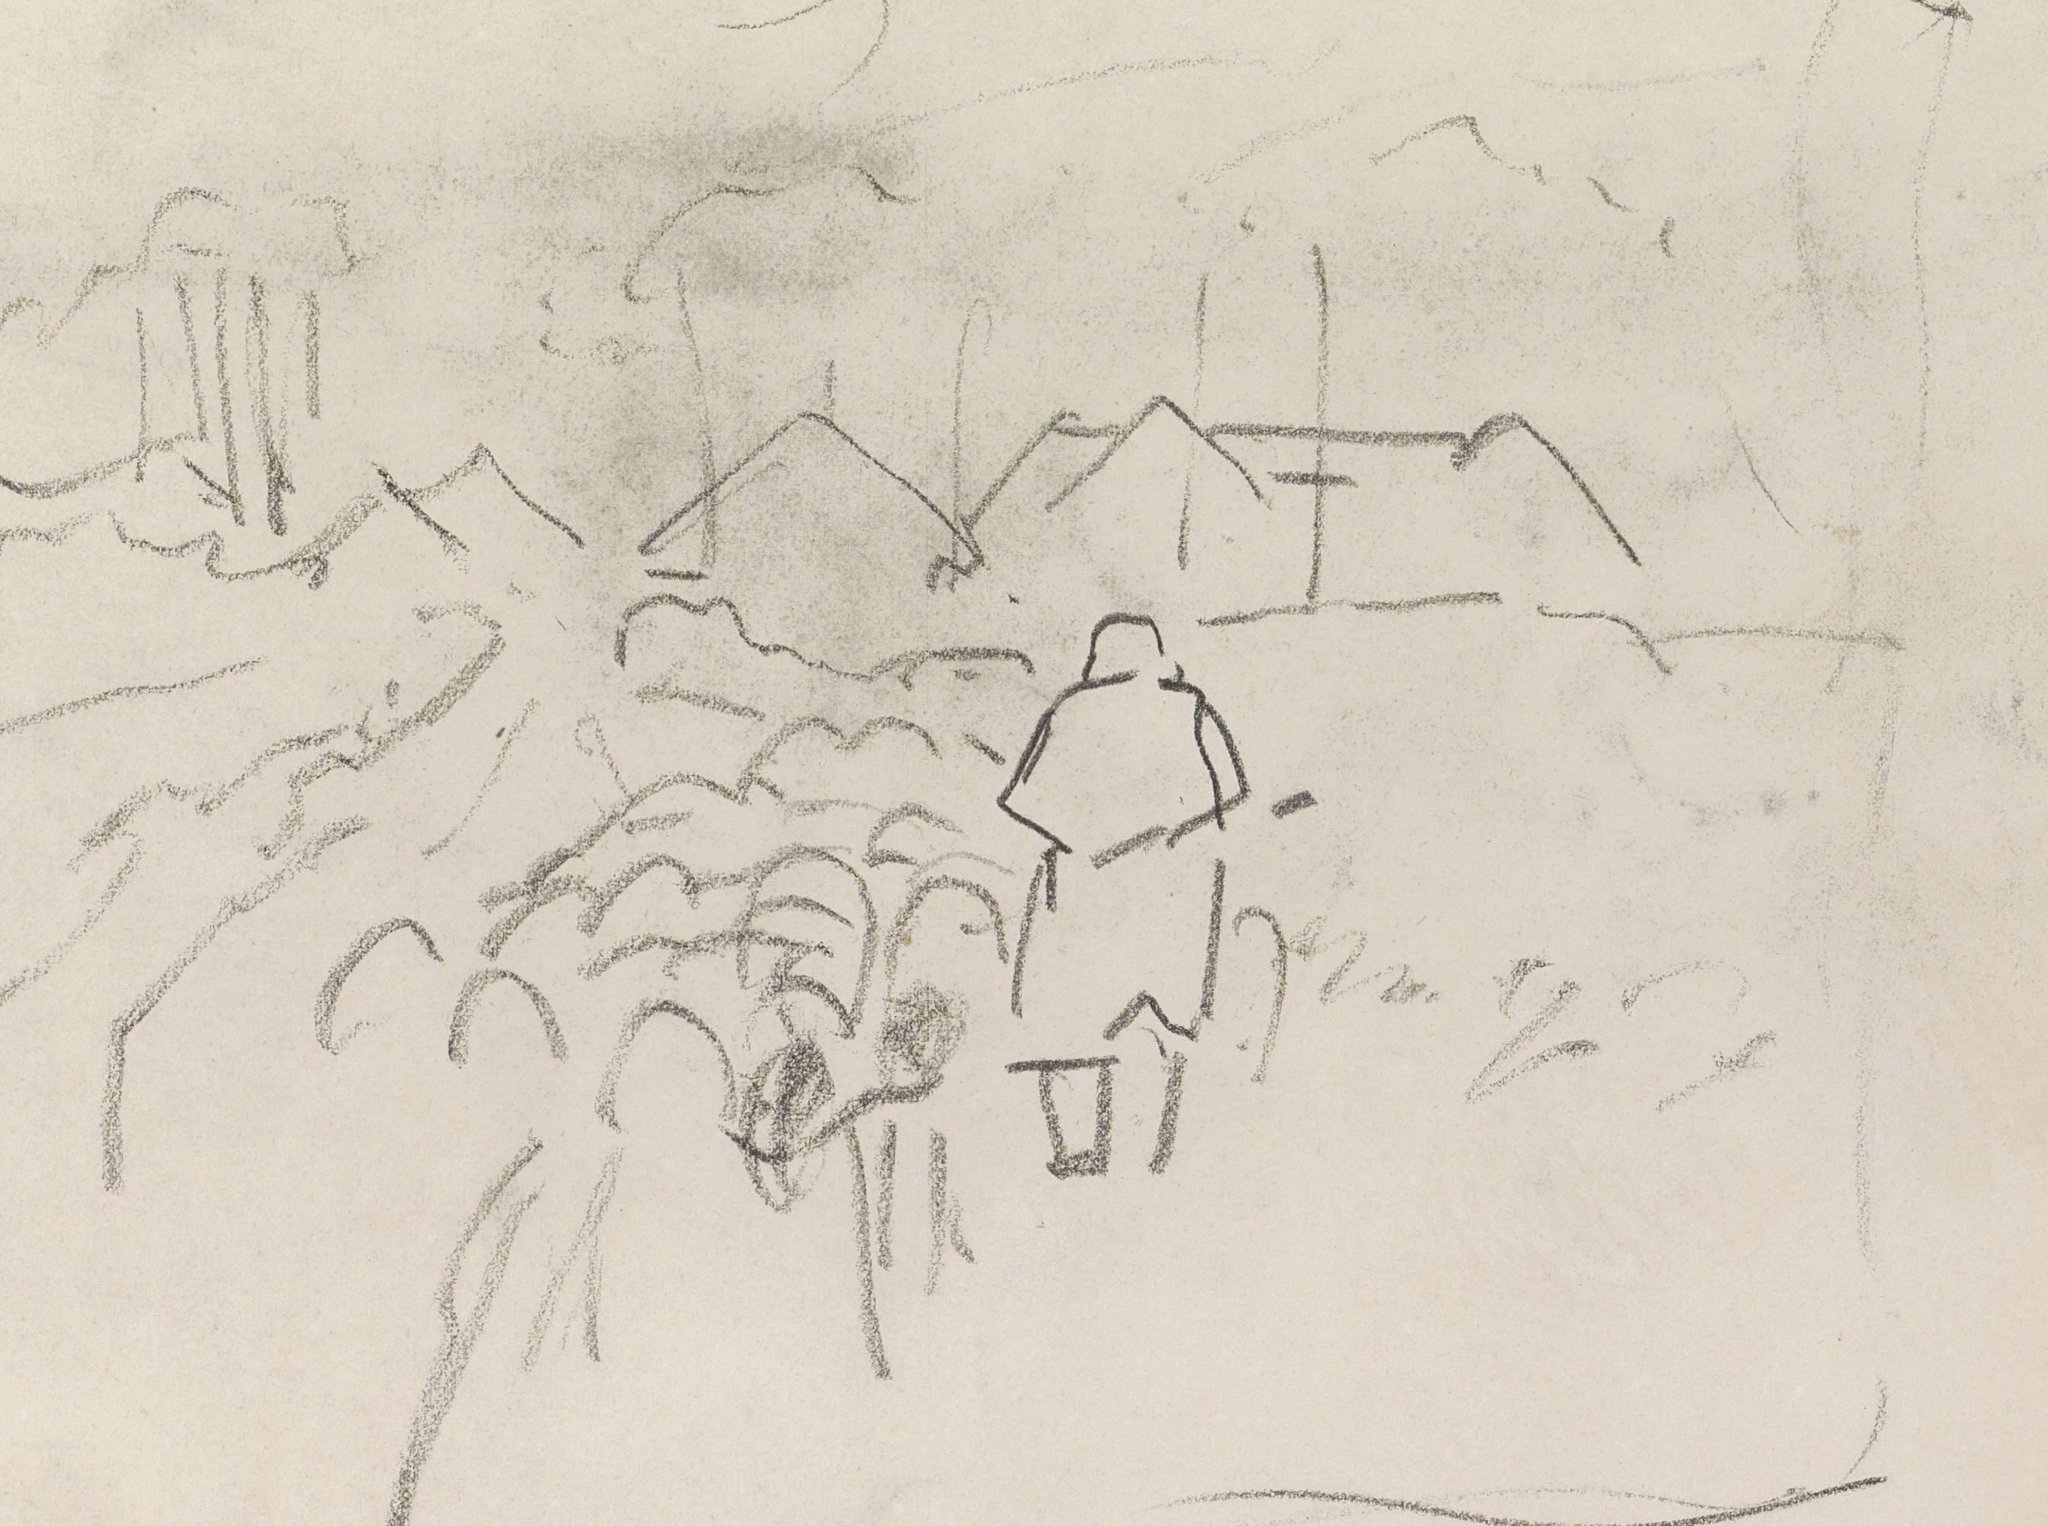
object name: sketchbook leaf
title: Herder met een schaapskudde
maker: anton mauve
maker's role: draughtsman, painter, print maker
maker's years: 1838-1888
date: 1886-1888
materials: chalk, paper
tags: herding, herdsman, herdswoman, shepherd, shepherdess, cowherd, etc., sheep, herd, flock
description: Op de achtergrond huizen, mogelijk van een boerderij. Blad 14 verso uit een schetsboek met 27 bladen.